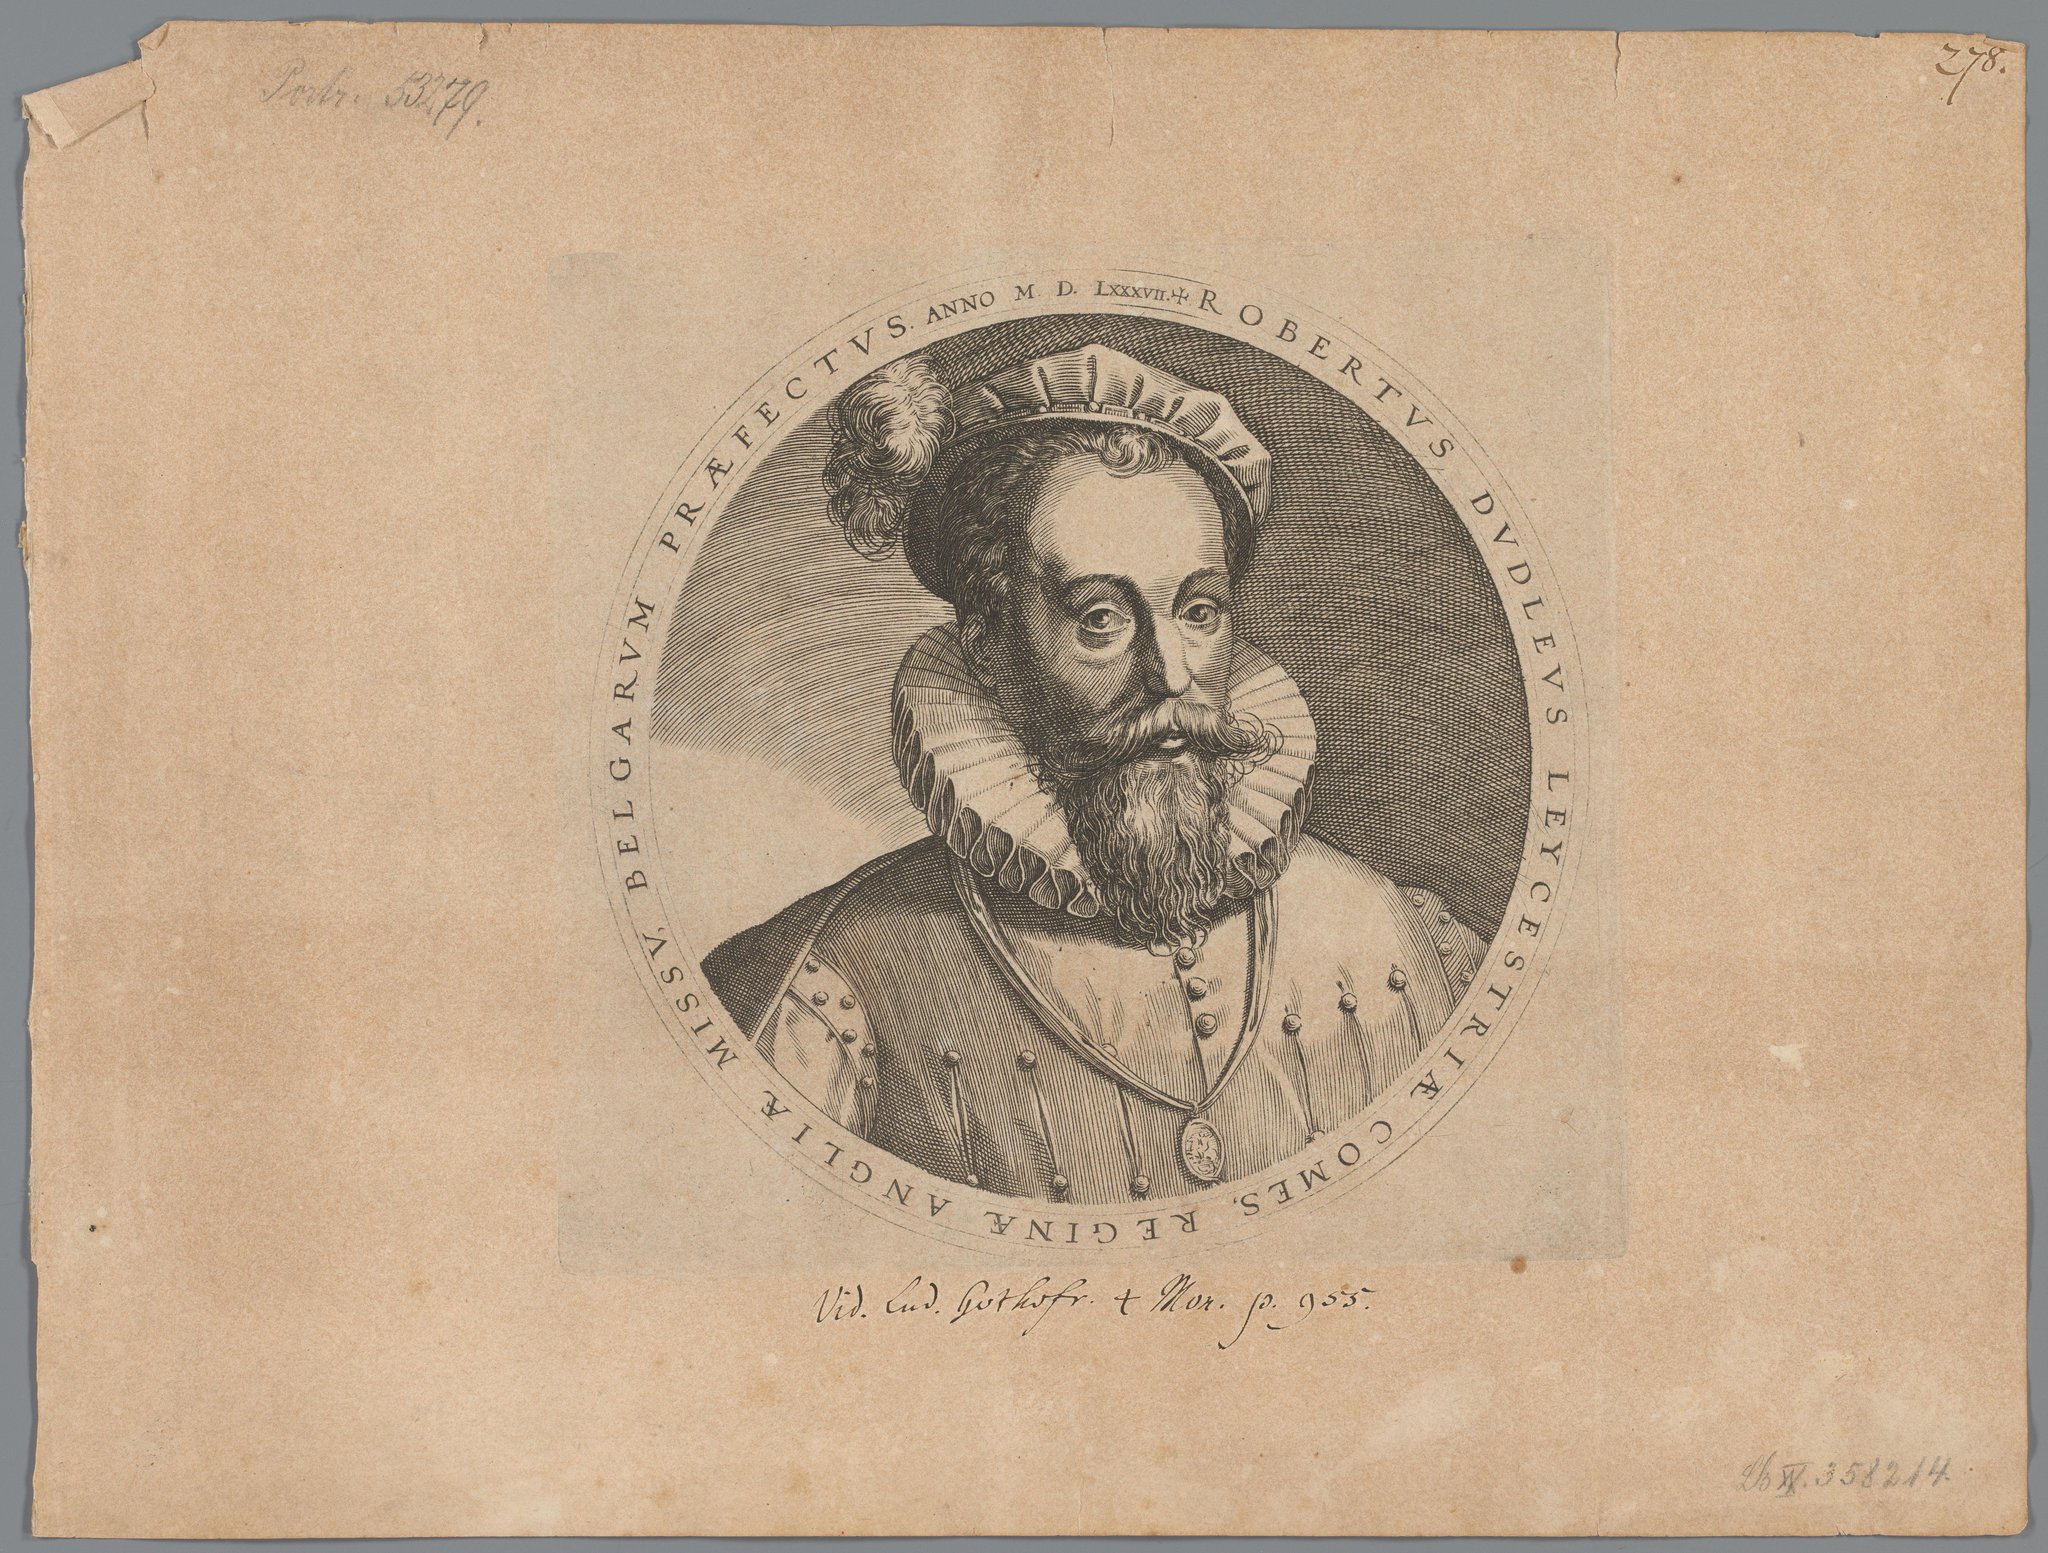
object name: print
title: Portret van Robert Dudley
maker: frans hogenberg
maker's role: print maker, publisher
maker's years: 1538-1590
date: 1596-1610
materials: paper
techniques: engraving, etching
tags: robert dudley (1st earl of leicester), official; civil servant; functionary (in general), historical persons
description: Eerdere staat waarschijnlijk uit: Meteren, Emanuel van. Historia, Oder Eigentliche und warhaffte Beschreibung aller fürnehmen Krigshändel (…). S.l.s.n., 1596. Ook uitgegeven in andere edities en vertalingen van Van Meteren, uit 1596, 1597, 1598, 1600 en 1610.